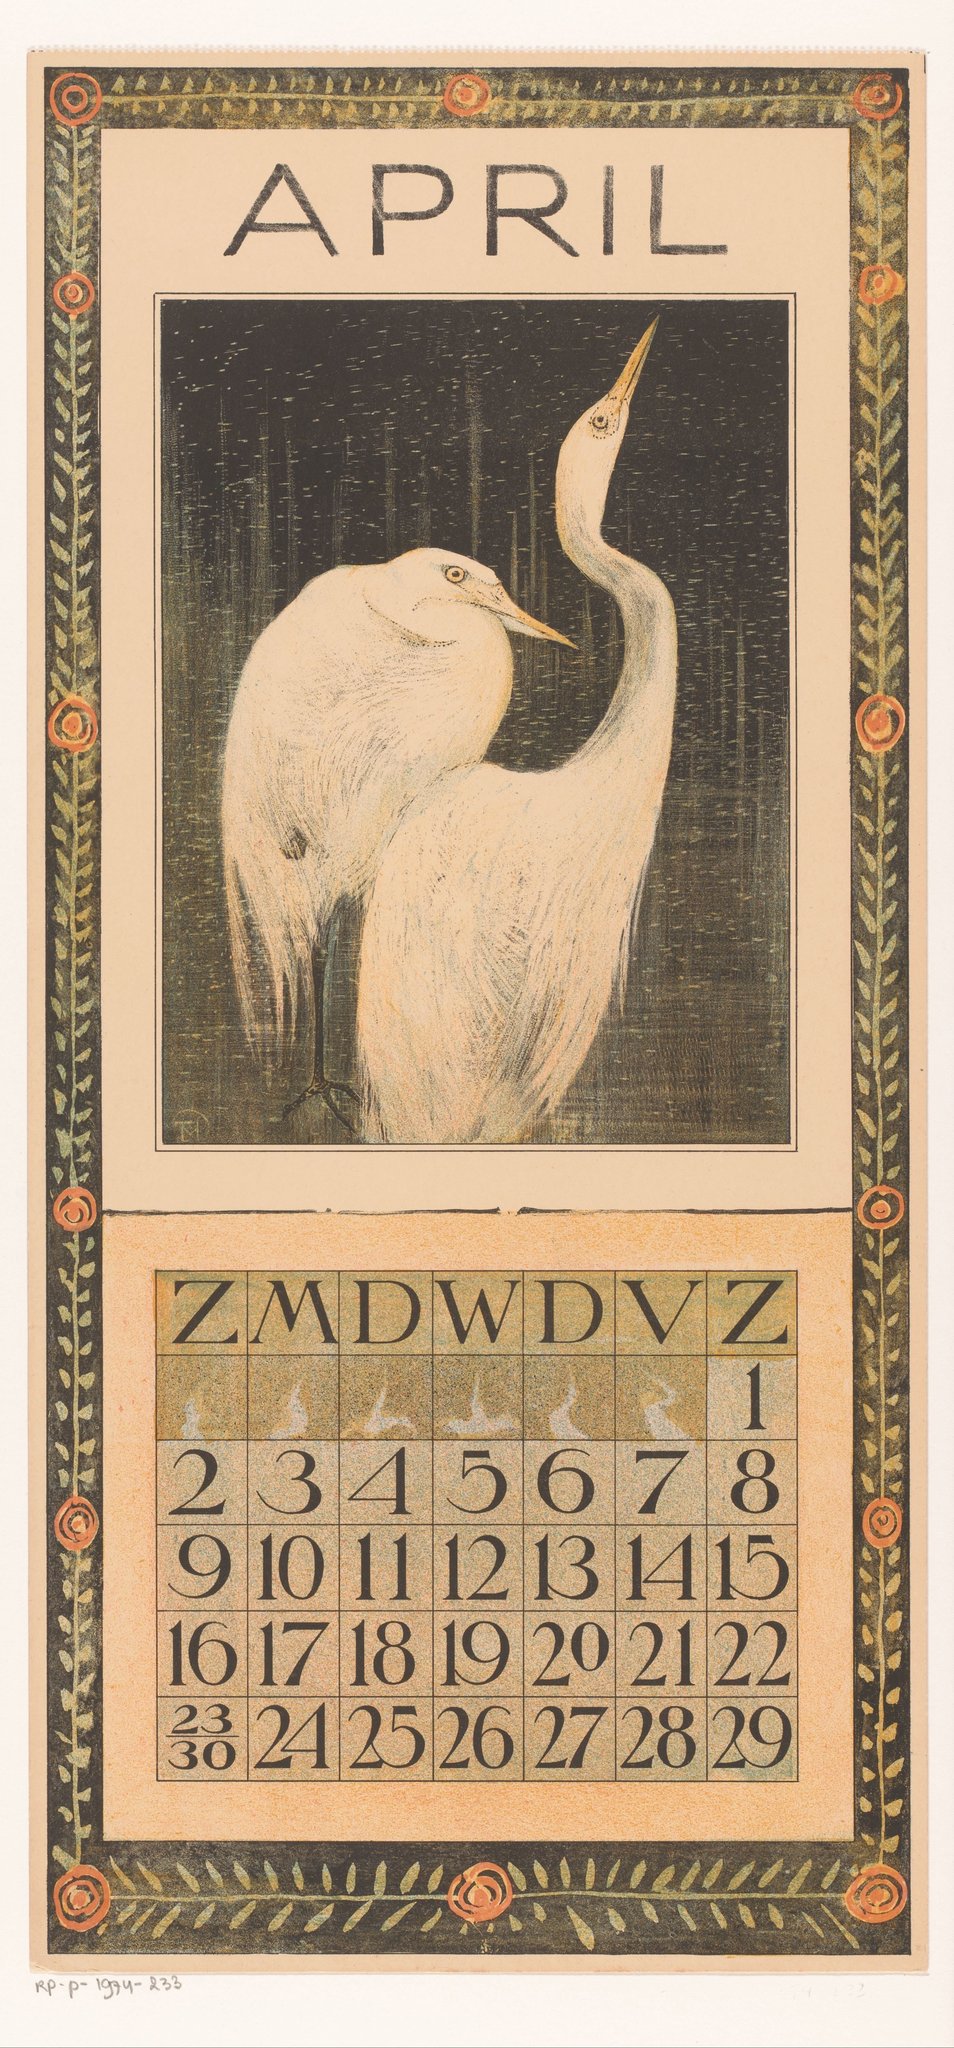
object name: calendar leaf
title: Kalenderblad april met zilverreigers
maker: theo van hoytema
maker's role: draughtsman, painter, print maker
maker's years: 1863-1917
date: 1904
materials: paper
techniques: lithograph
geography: amsterdam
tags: shore-birds and wading-birds: heron, april ~ other concepts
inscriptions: collector's mark: Lugt 2228